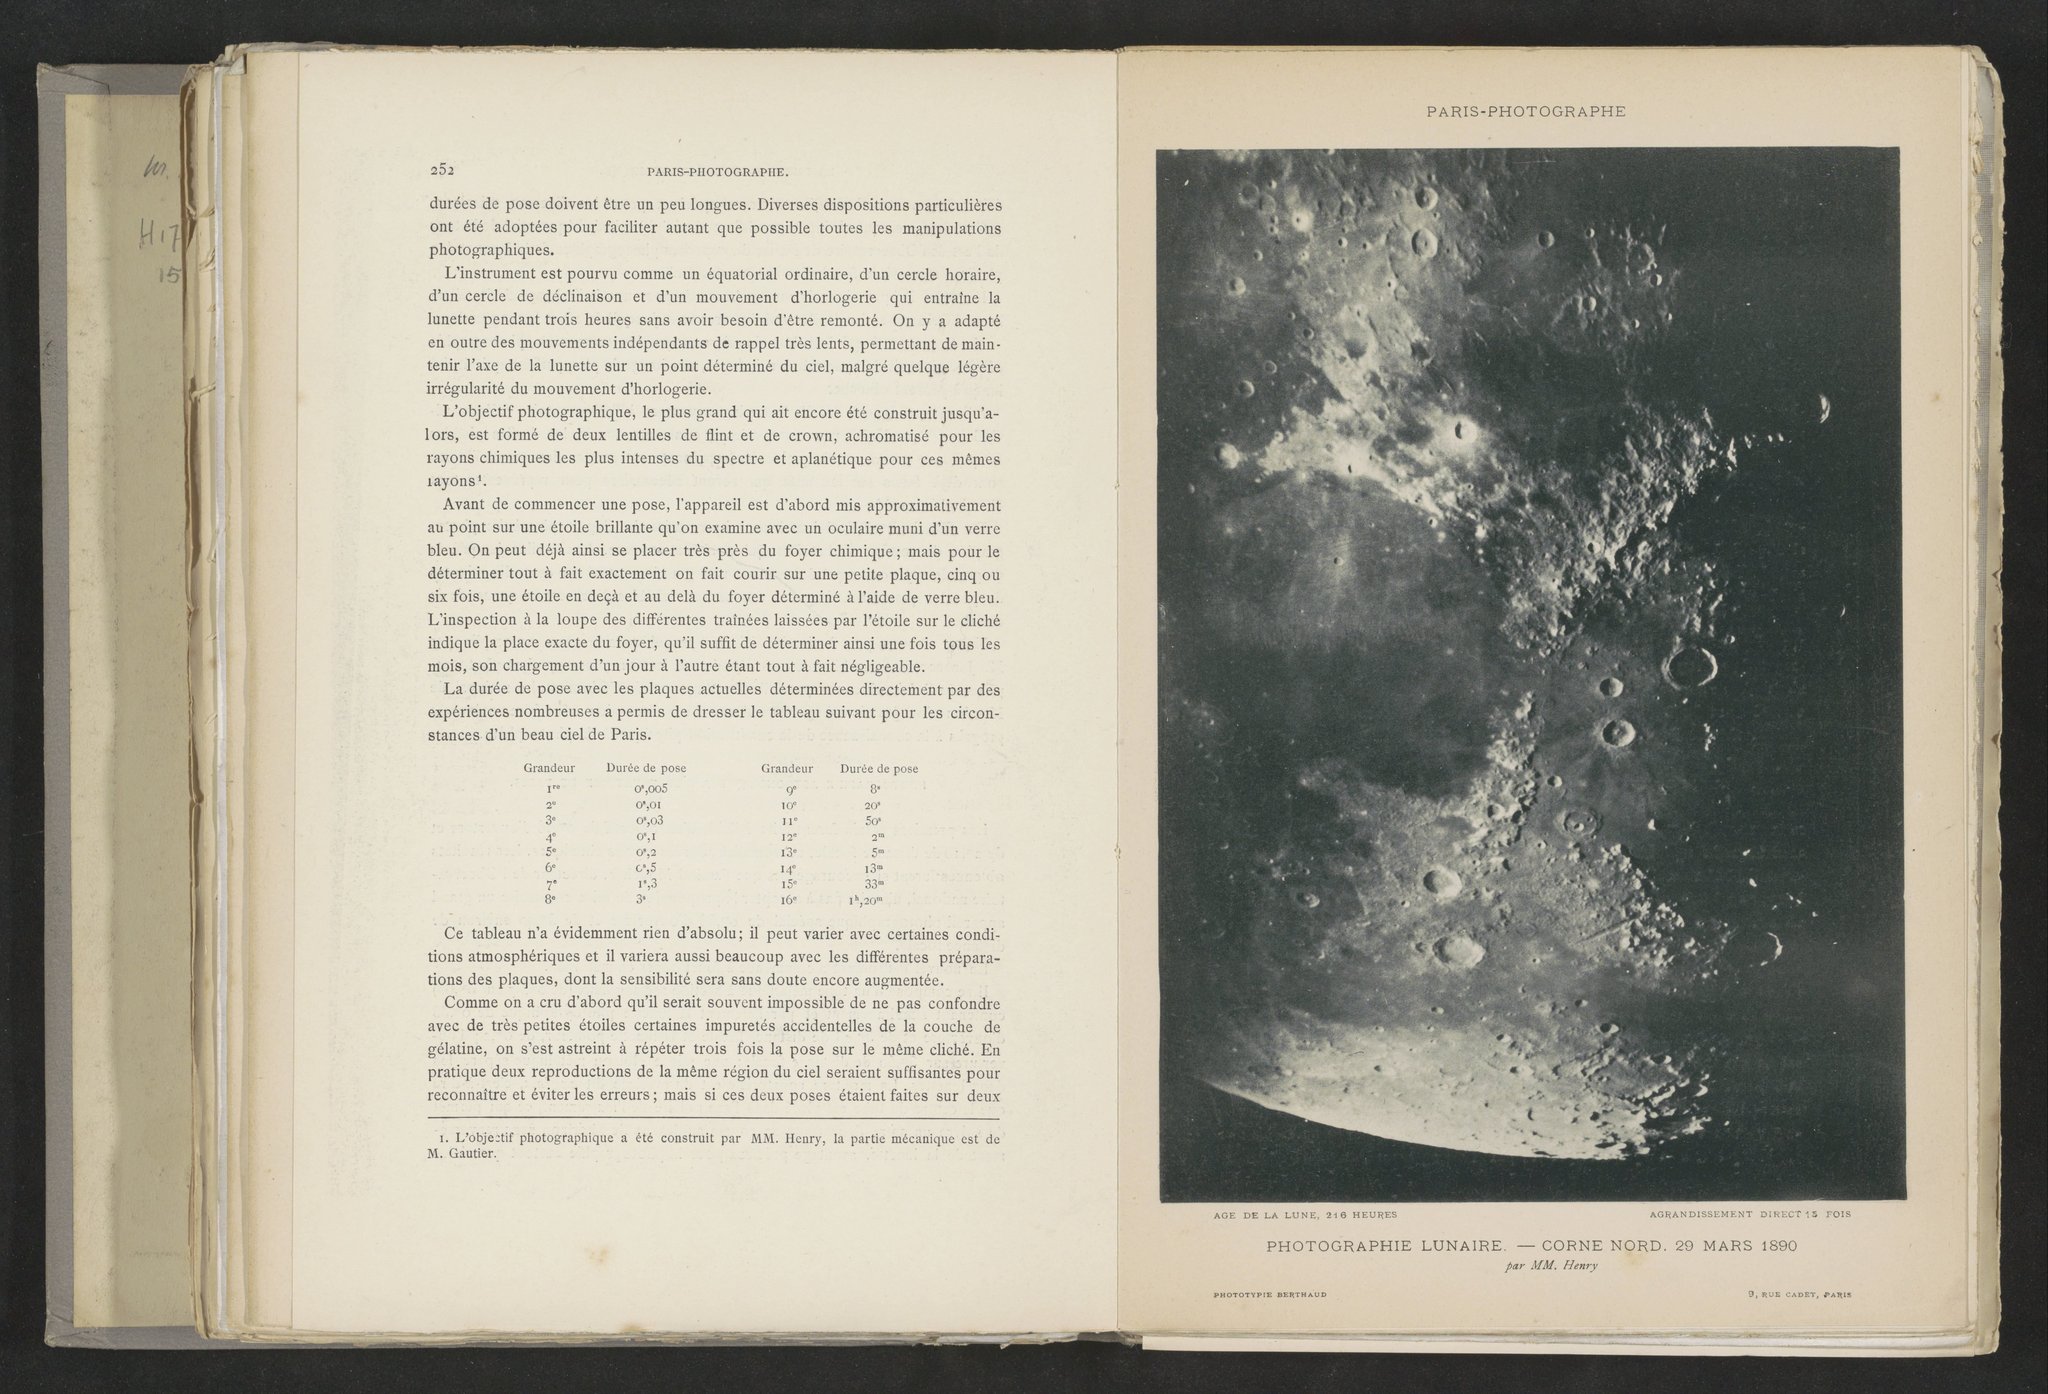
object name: photomechanical print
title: Photographie lunaire - corne nord 29 mars 1890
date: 1890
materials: paper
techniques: photograph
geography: france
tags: surface of the moon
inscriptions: inscription: ‘age de la lune, 216 heures agrandissement direct 15 fois’